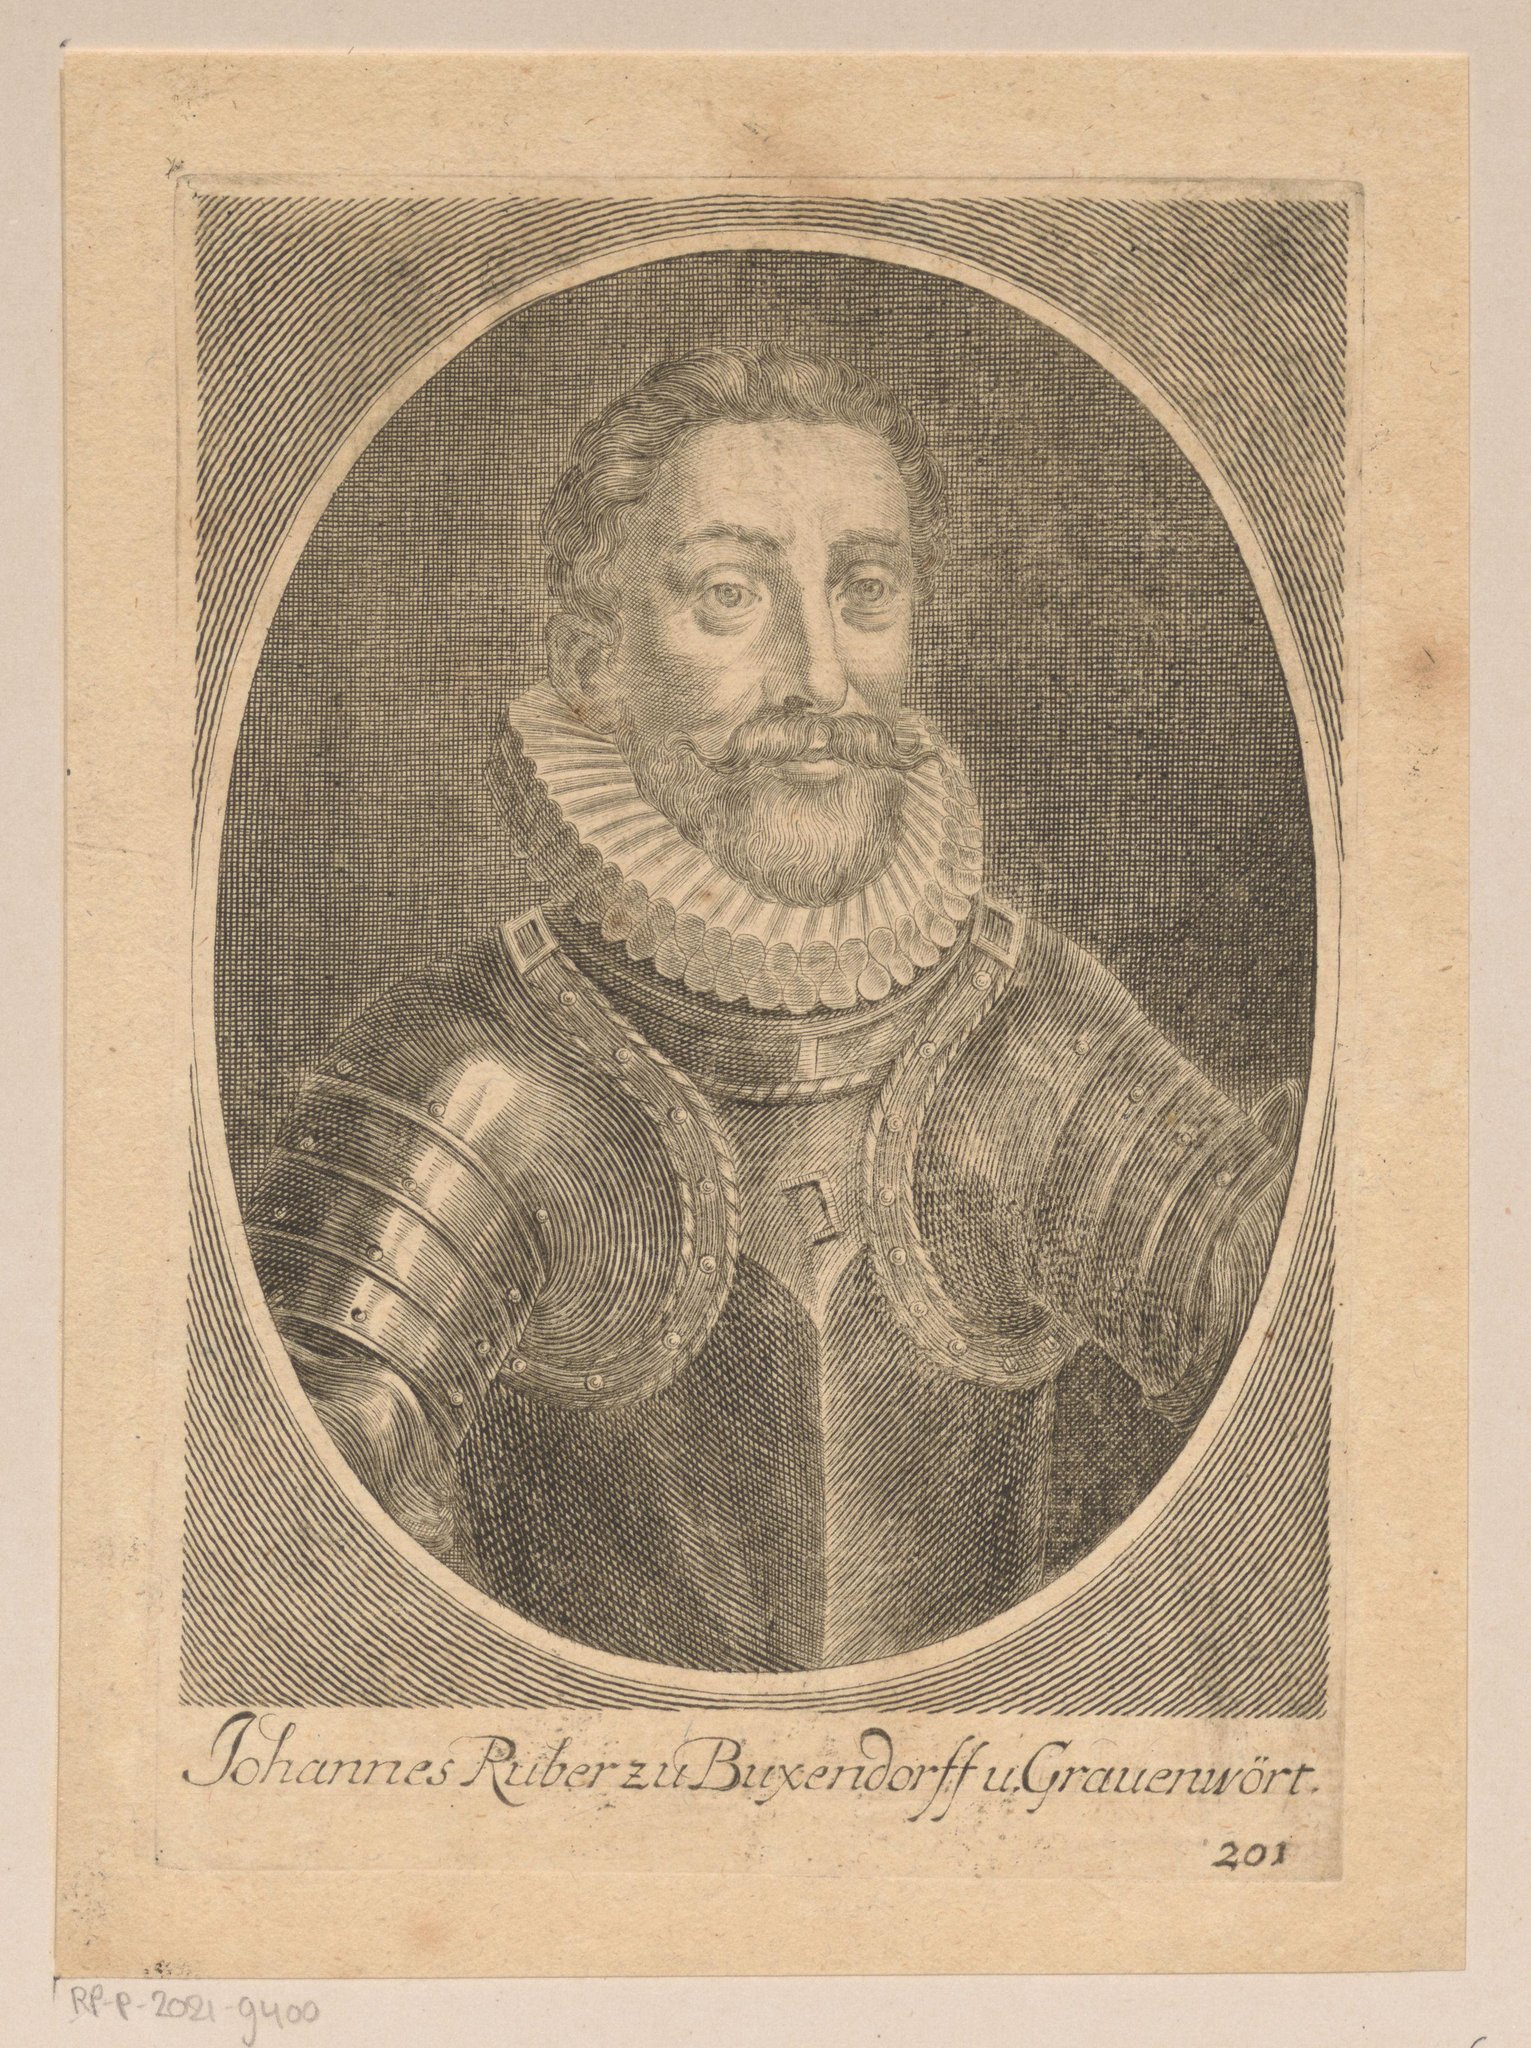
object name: print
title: Portret van Johann Rueber zu Büxendorff und Grafenwerdt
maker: Anonymous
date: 1721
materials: paper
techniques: engraving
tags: armour, historical persons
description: Portretten met omlijsting zijn gebruikt in: Khevenhüller, Franz Christoph. Conterfet Kupfferstich (...). 2 dln. Leipzig: Moritz Georg Weidmann, 1721, dl. 1.